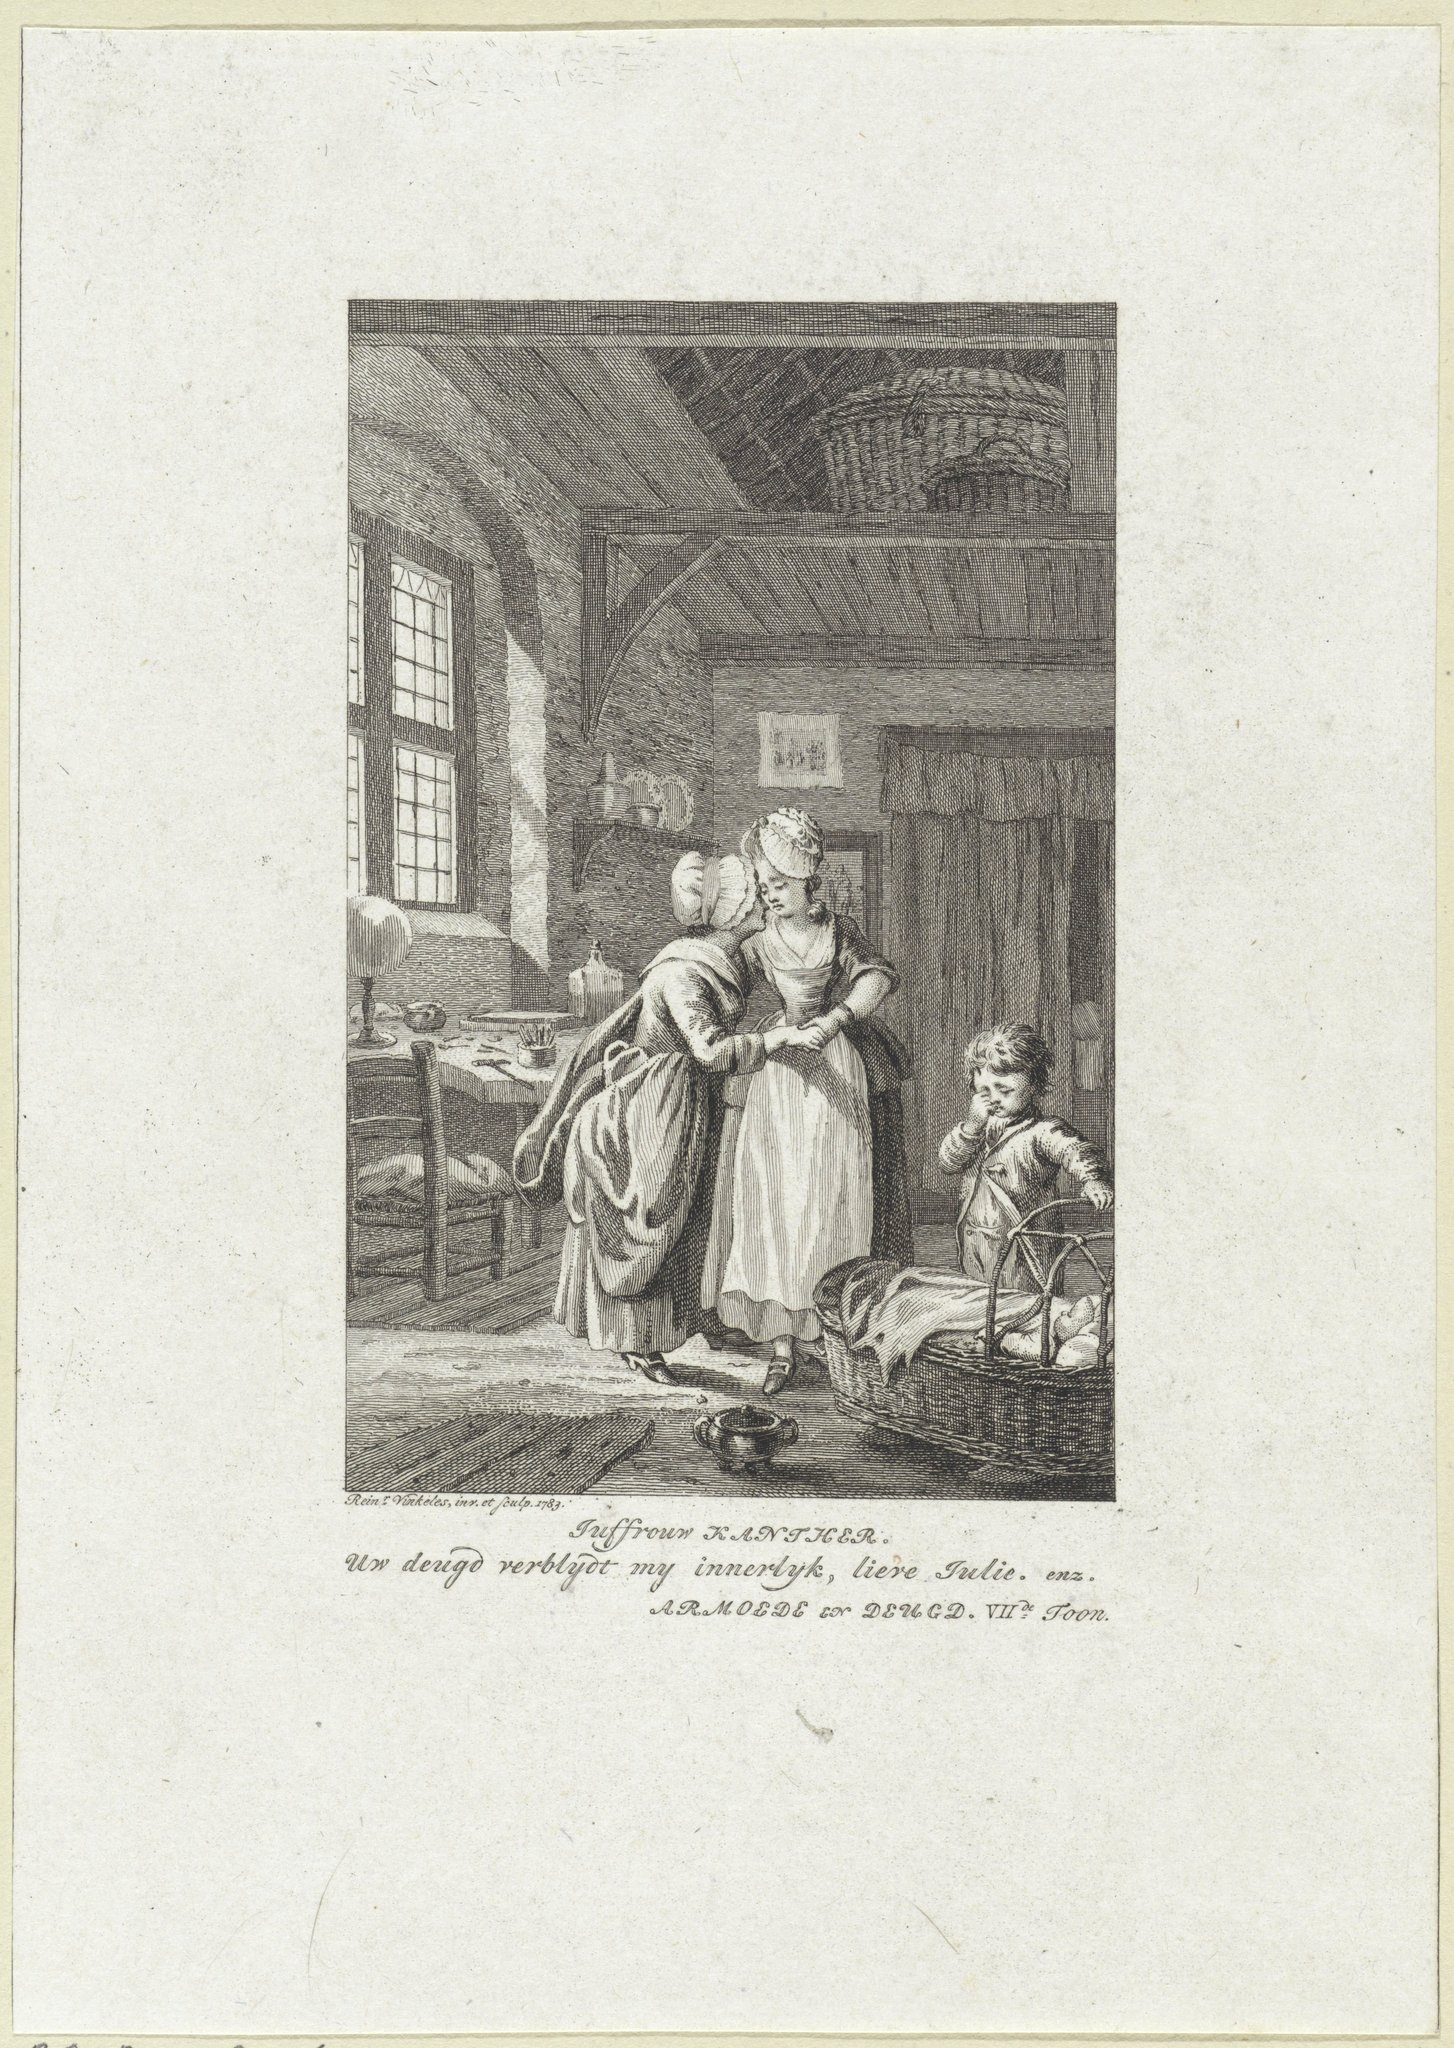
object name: print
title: In een bescheiden interieur fluistert een vrouw een andere vrouw iets in het oor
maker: reinier vinkeles (i)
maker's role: draughtsman, print maker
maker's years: 1741-1816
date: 1783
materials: paper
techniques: engraving, etching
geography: amsterdam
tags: whispering, weeping, the poor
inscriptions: collector's mark: Lugt 240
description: Deze prent is mogelijk gebruikt als illustratie in: Weisse, Christian Felix. Armoede en Deugd. Amsterdam: Pieter Meĳer, 1783.